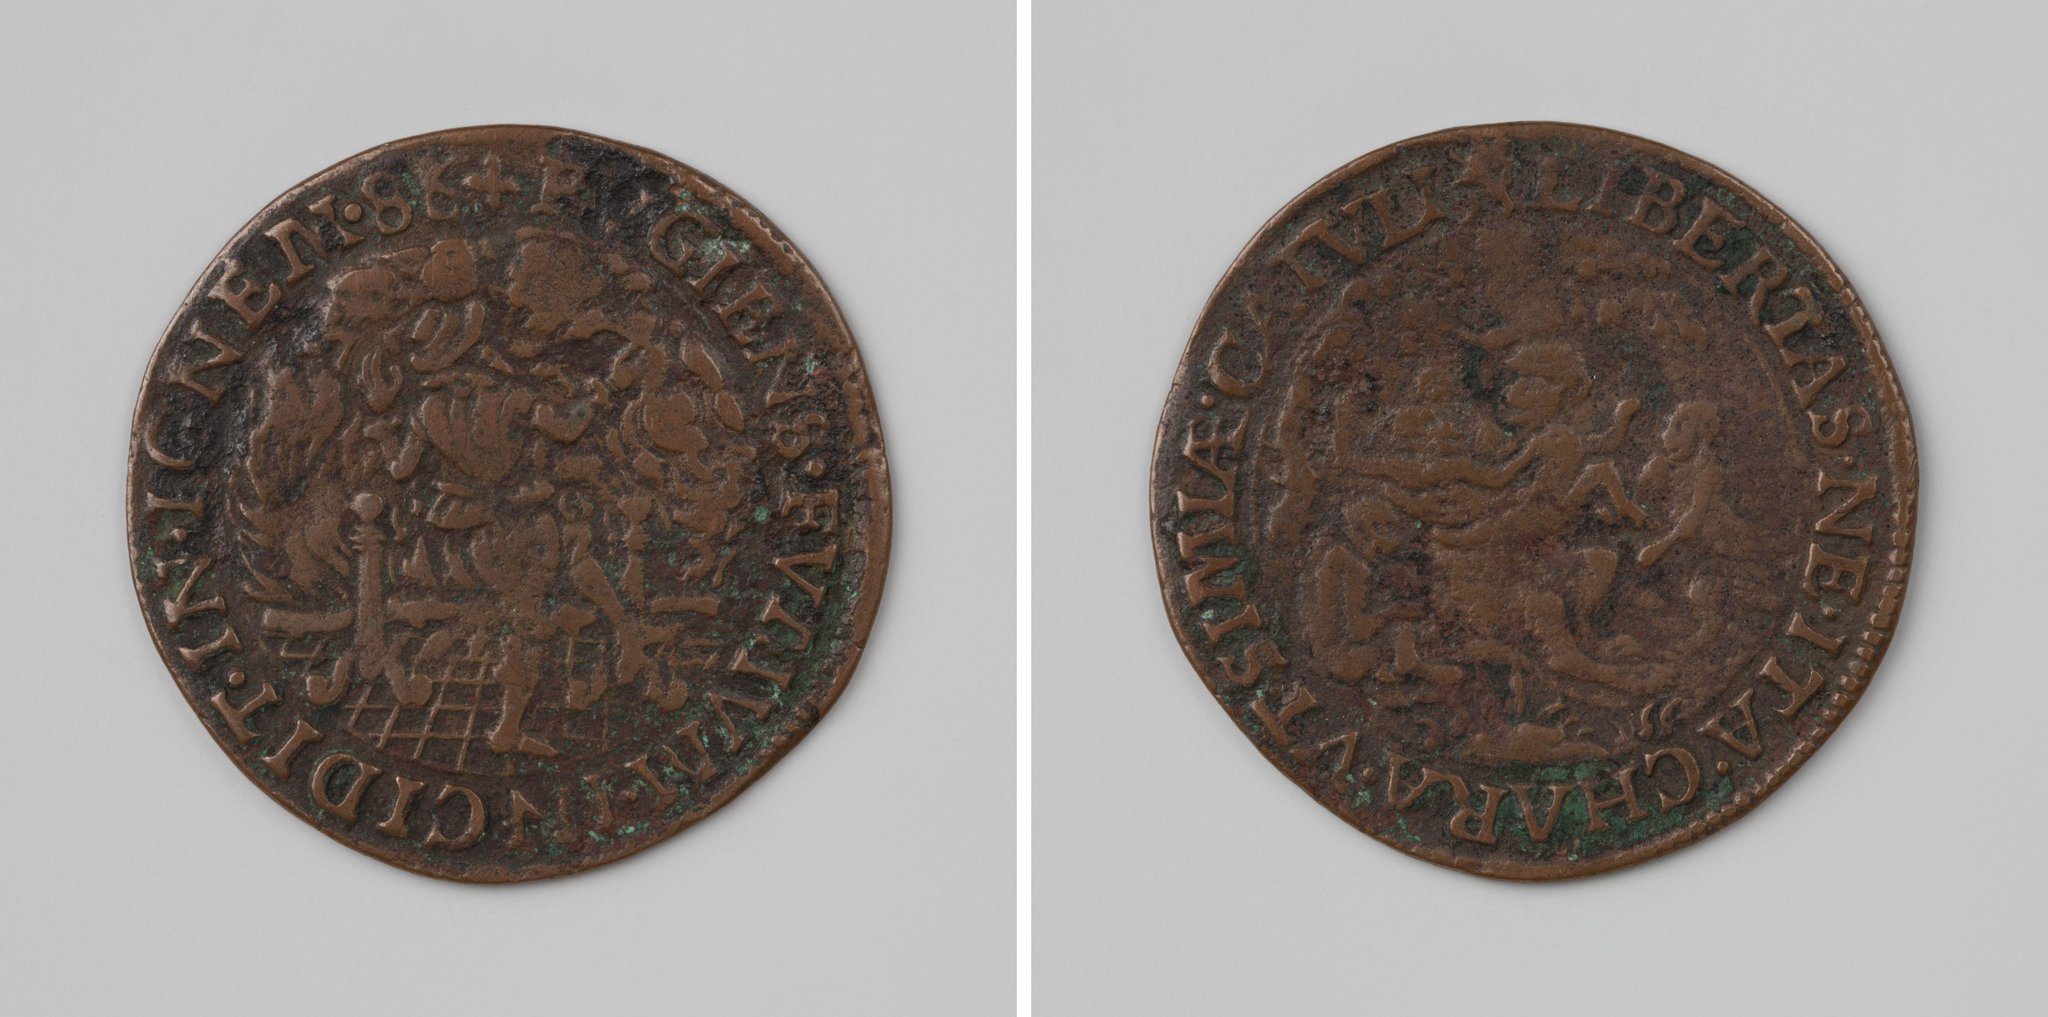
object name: jeton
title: Allegorische waarschuwing voor de onbetrouwbaarheid der Engelse bondgenoten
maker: Anonymous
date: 1586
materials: copper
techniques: striking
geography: dordrecht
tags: tachtigjarige oorlog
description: Koperen penning. Voorzijde: man, die rook ontvlucht en in vuur terecht komt binnen omschrift. Keerzijde: aap met jongen binnen omschrift